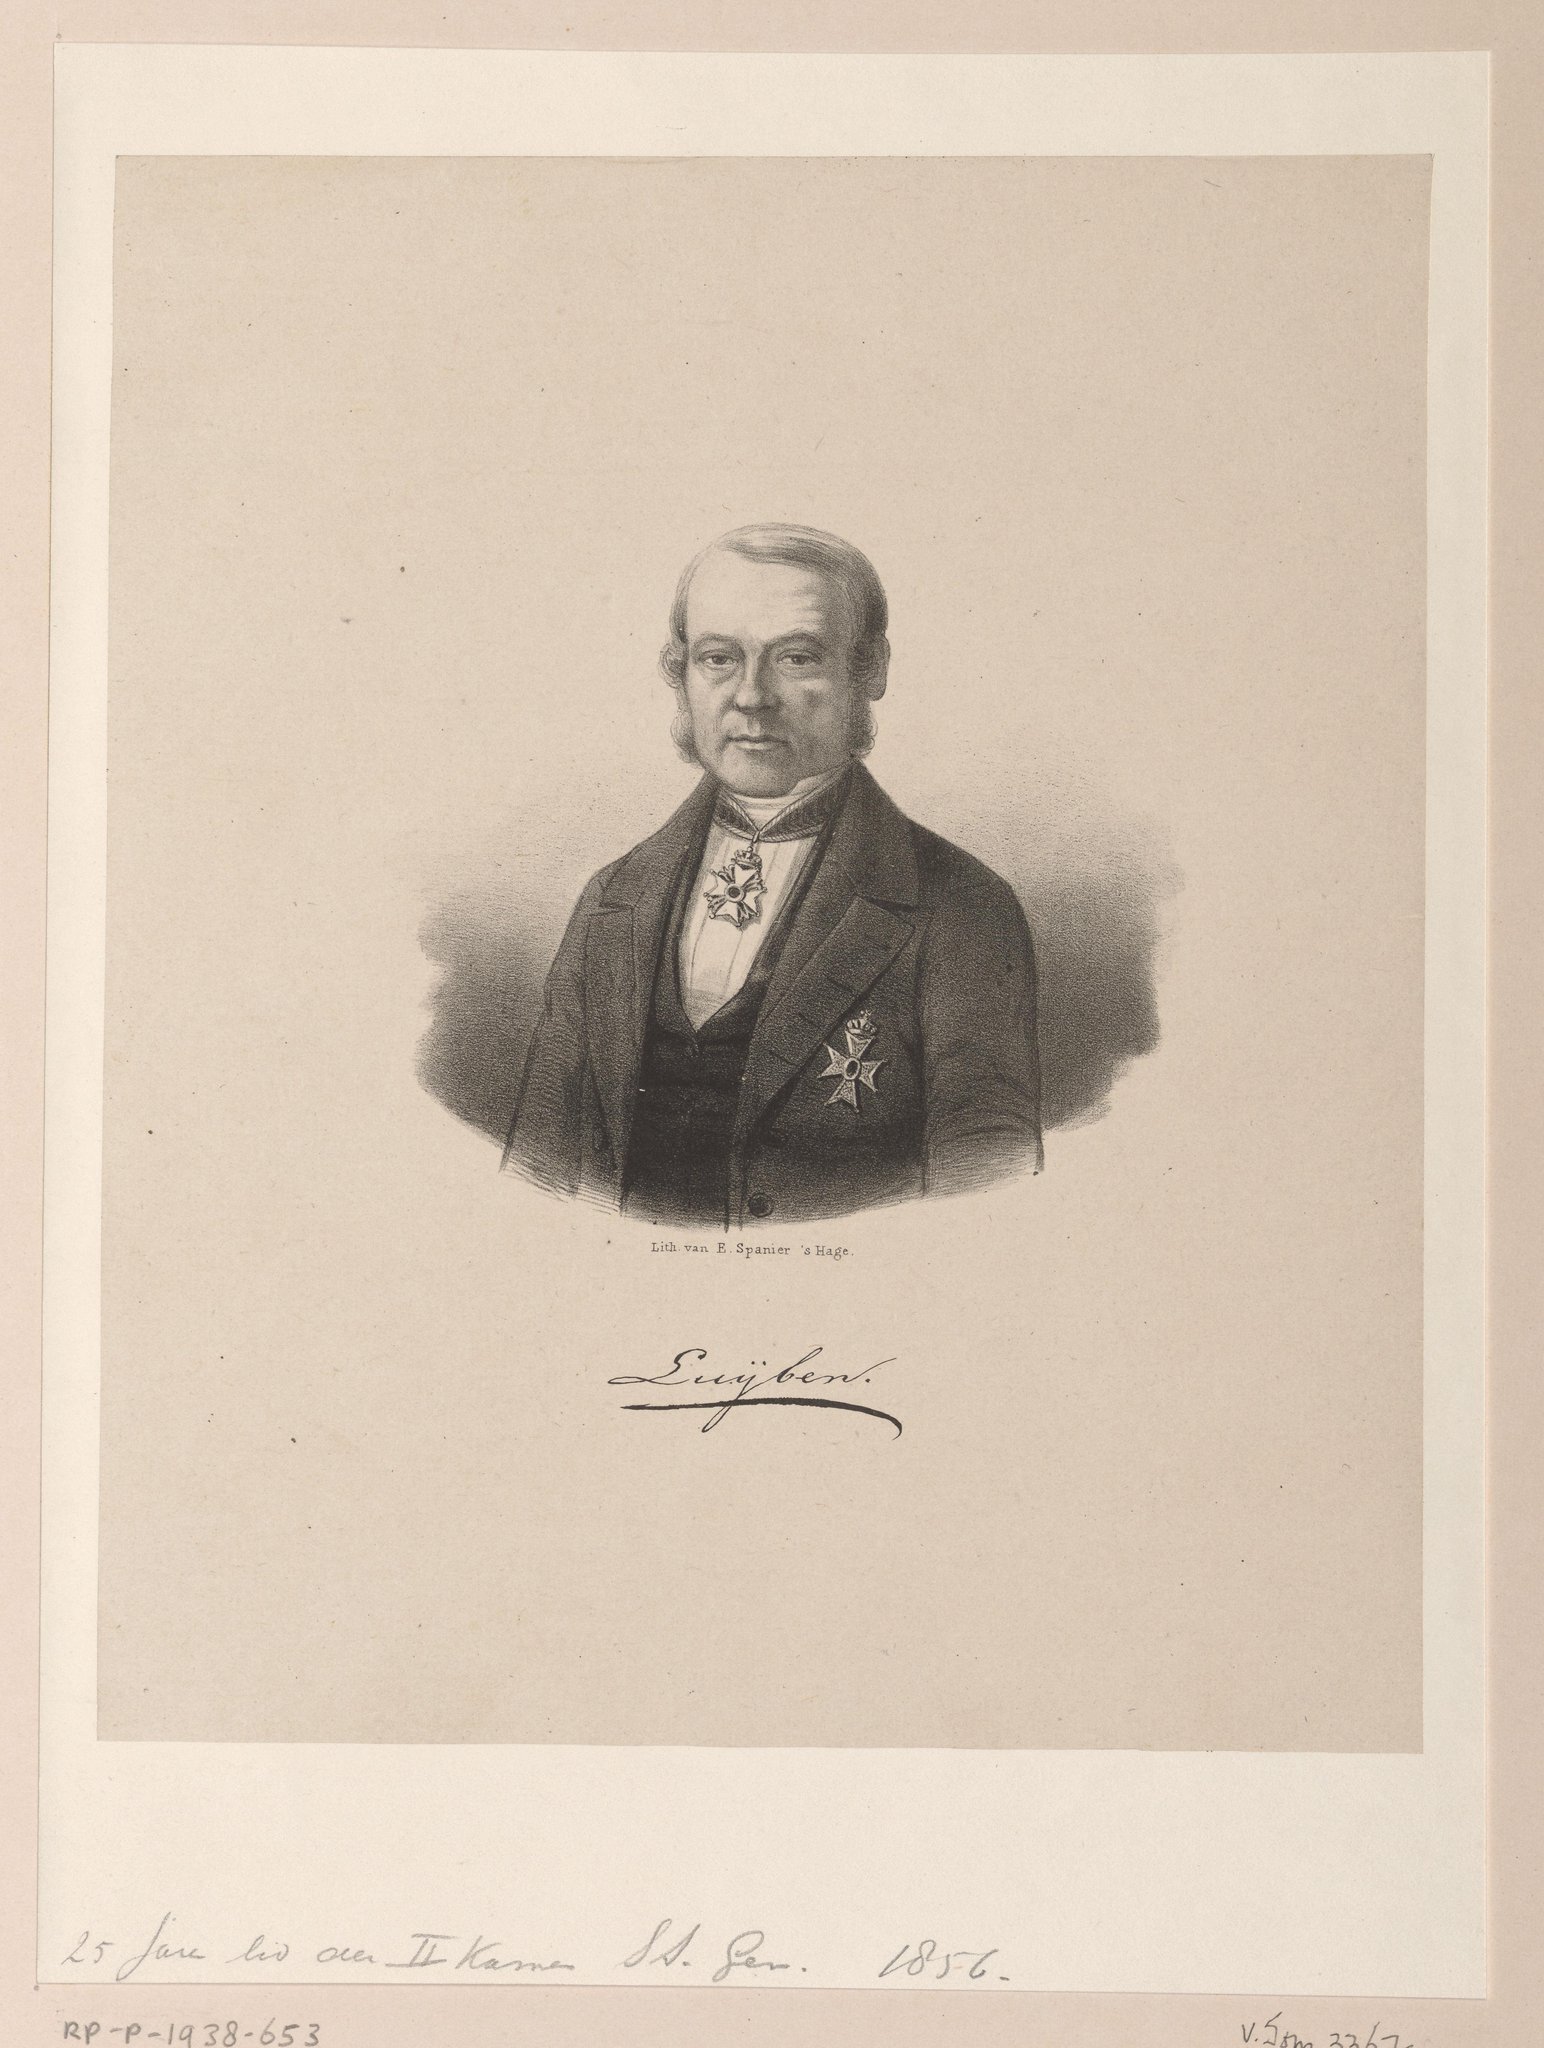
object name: print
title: Portret van Johannes Lambertus Antonius Luyben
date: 1843-1856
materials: paper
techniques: lithograph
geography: the hague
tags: delft, den bosch, politician, historical persons, politician, e.g. party leader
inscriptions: collector's mark: Lugt 2228, inscription: ‘25 Jare lid der II Kamer St. Gen. 1856.’